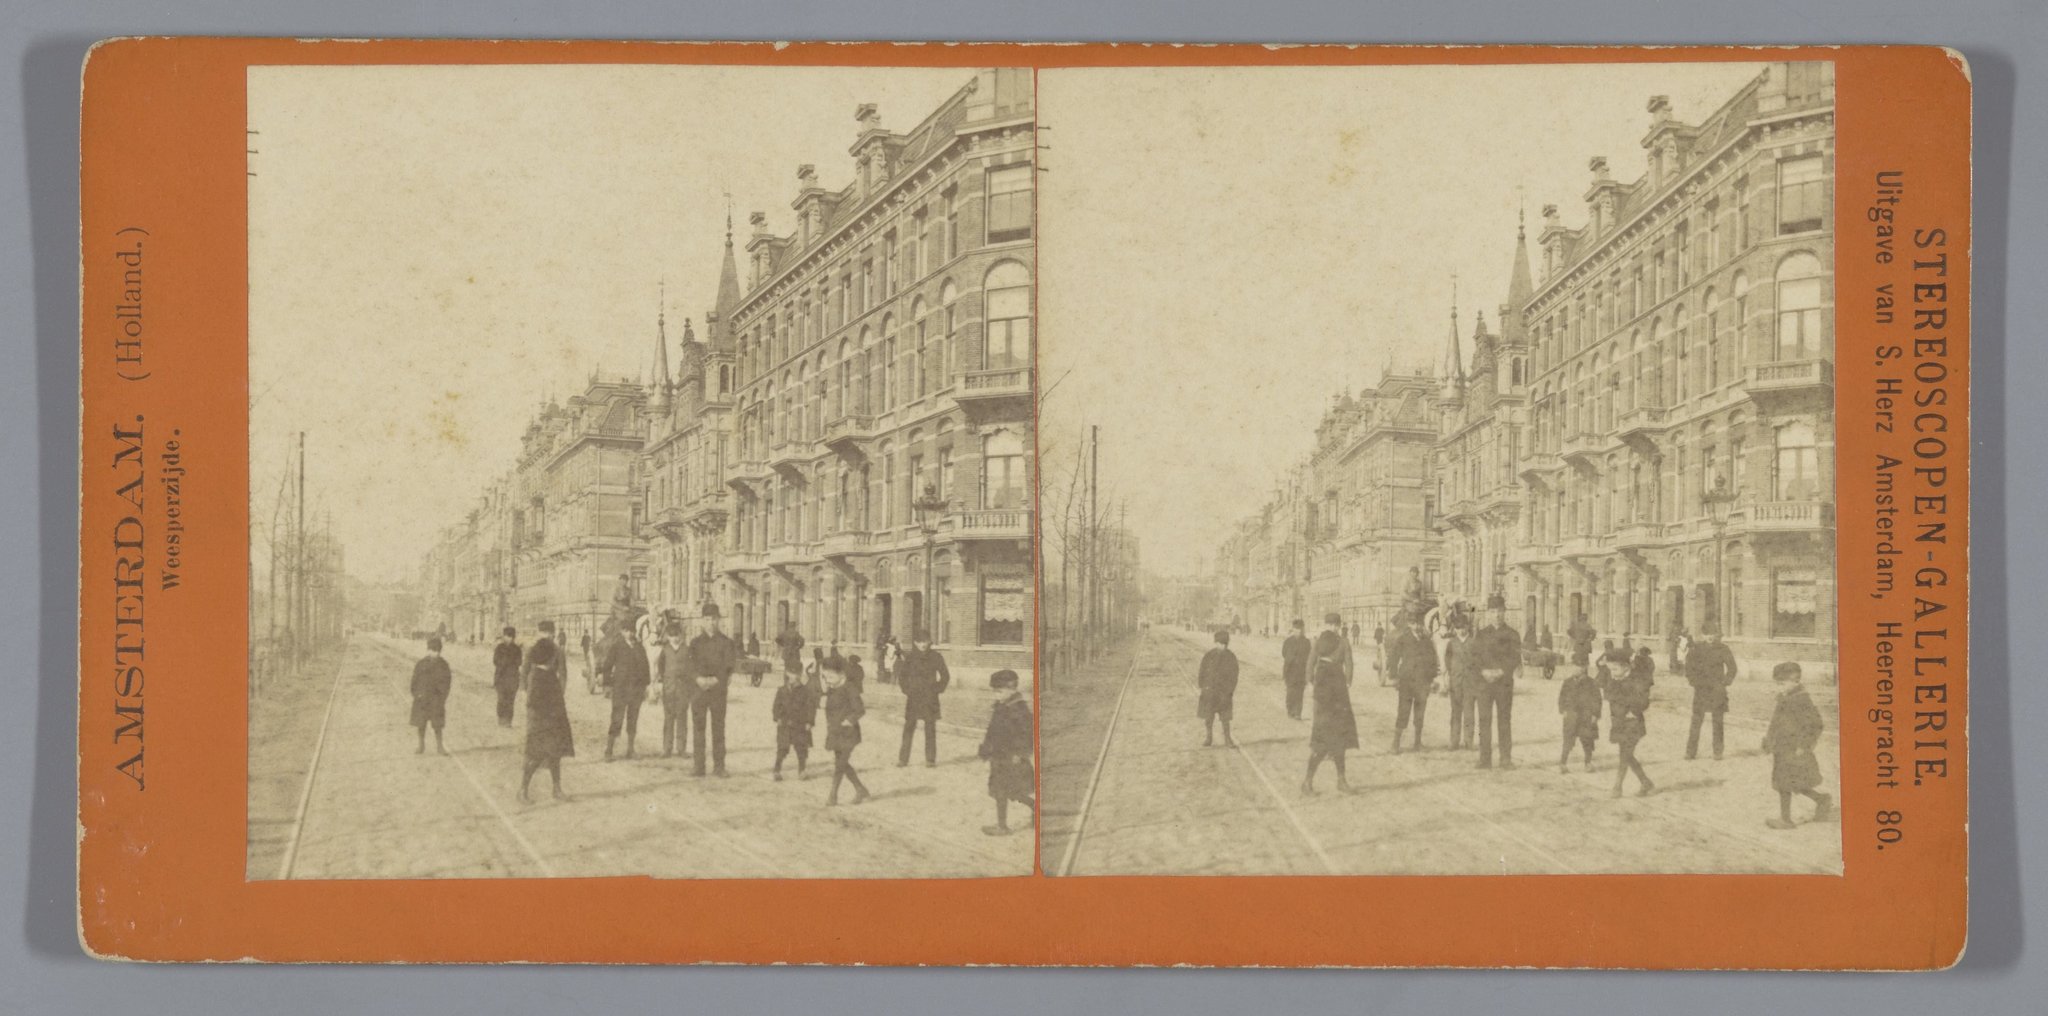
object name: stereograph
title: Amsterdam, Weesperzijde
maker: sigmund löw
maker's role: publisher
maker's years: 1845-1920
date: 1892-1902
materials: cardboard, paper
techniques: albumen print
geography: amsterdam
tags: street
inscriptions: number: ‘No 176’, address: ‘Heerengracht 80’